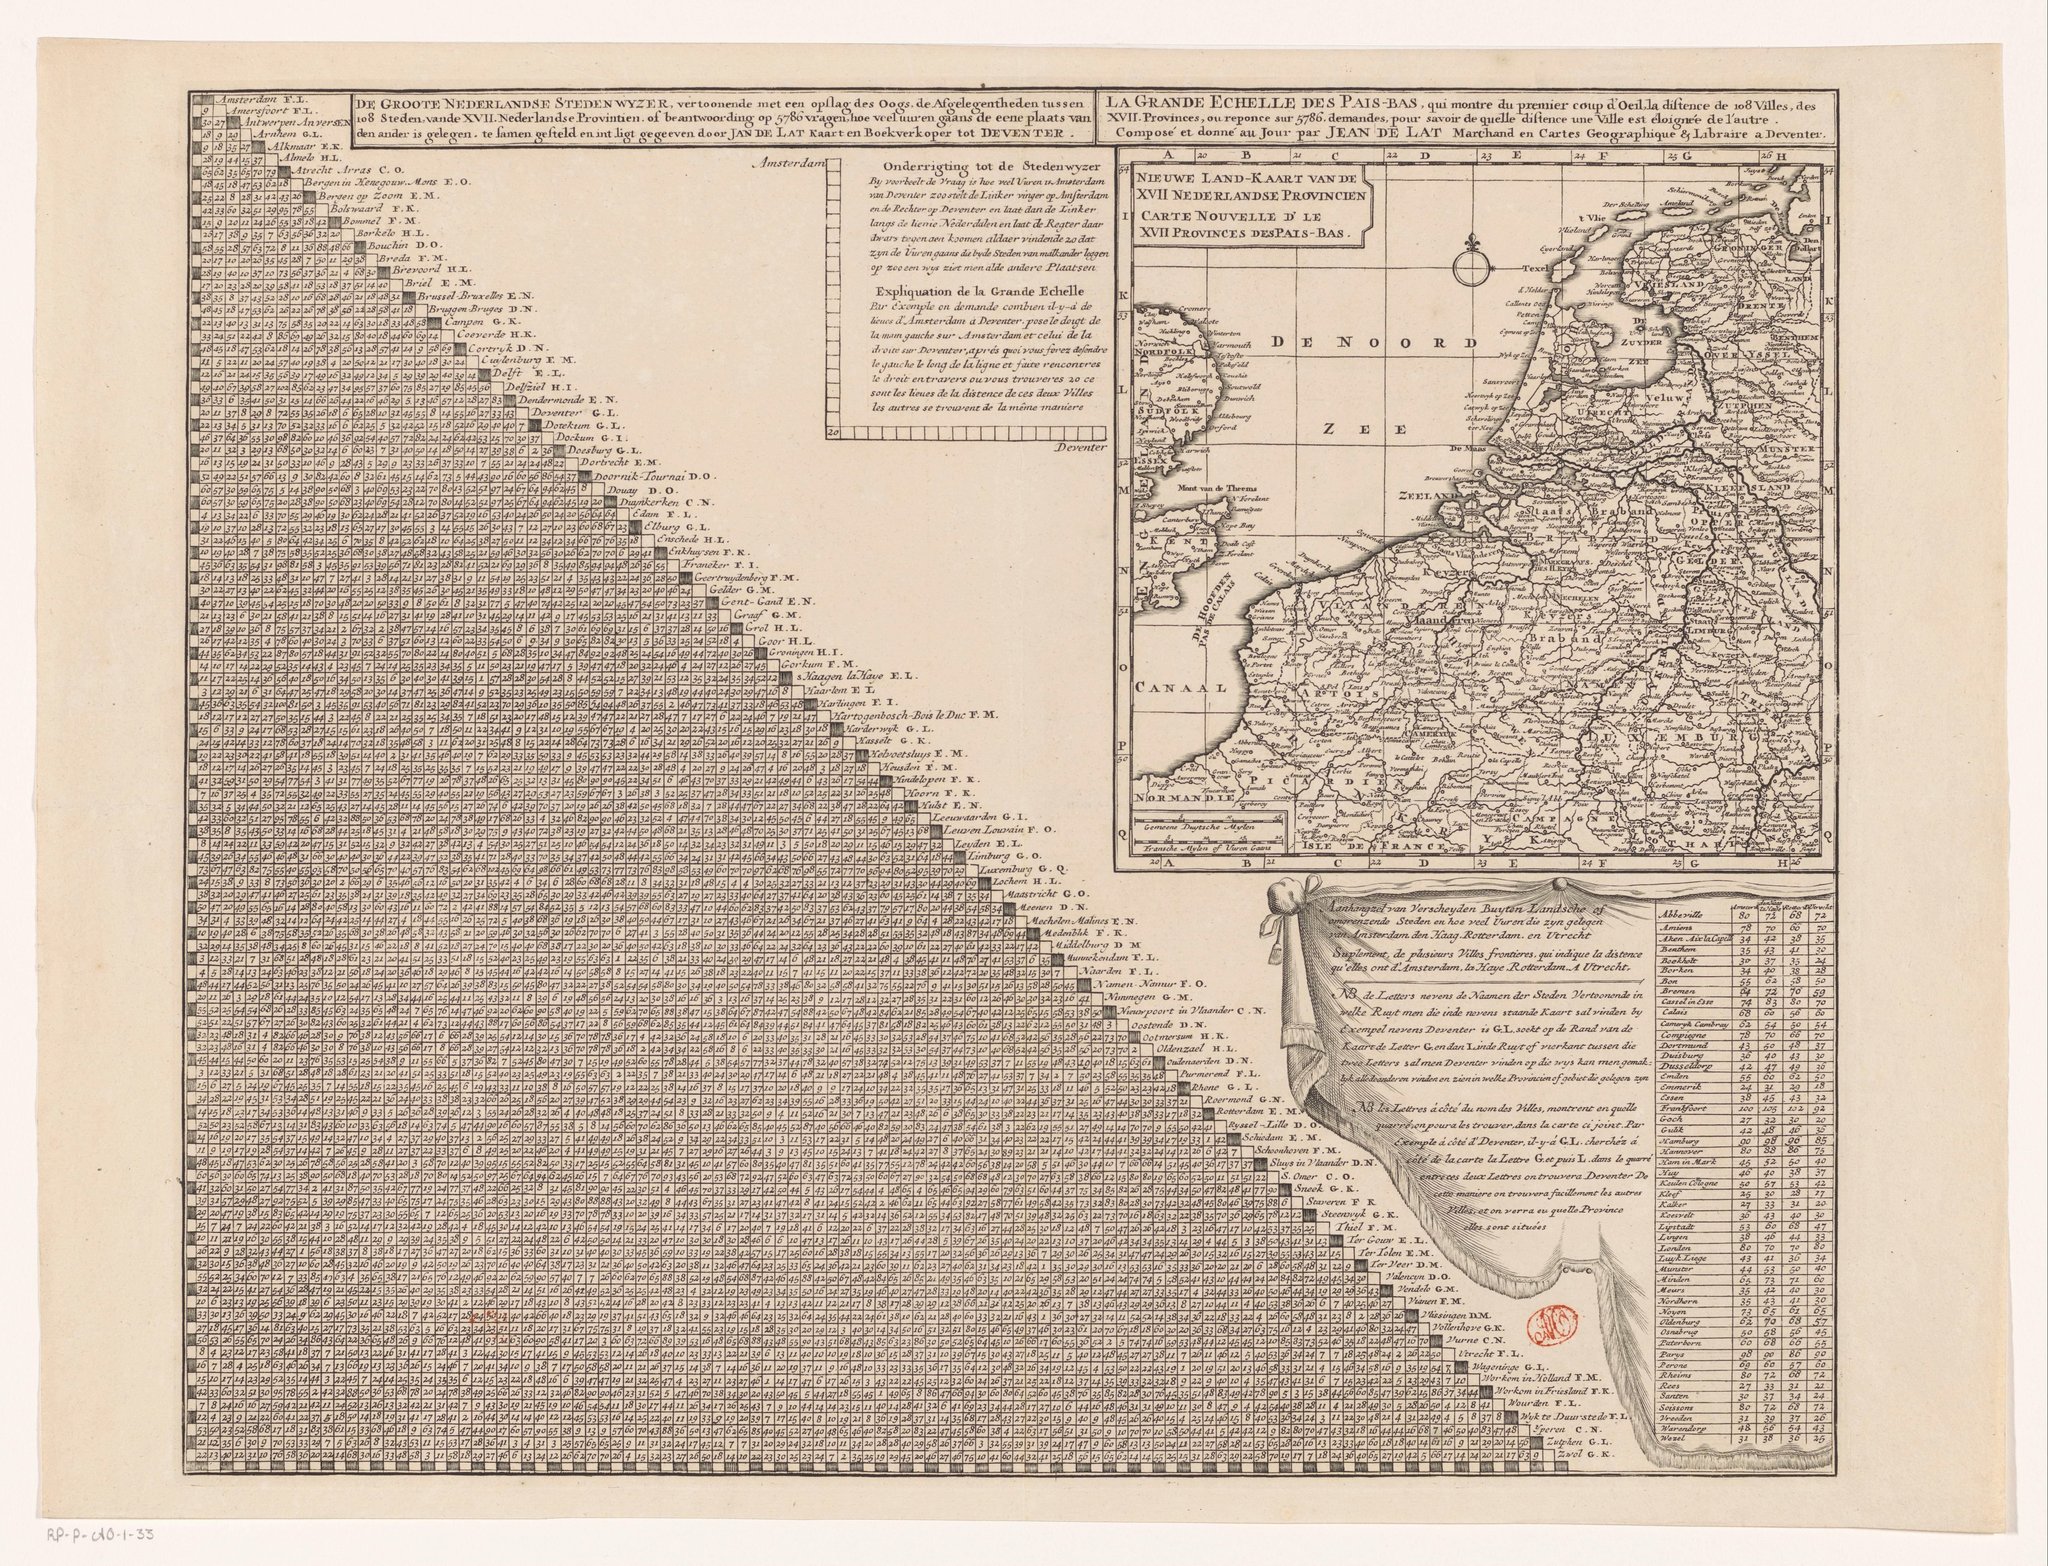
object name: print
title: Kaart van de Zeventien Provinciën met afstandstabel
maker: jan de lat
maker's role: bookseller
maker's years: 1683-1756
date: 1731-1740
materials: paper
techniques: engraving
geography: deventer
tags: maps of separate countries or regions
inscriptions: collector's mark: Lugt 195, collector's mark: Lugt 2228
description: Links een afstandstabel waarin staat hoeveel loopuren 108 belangrijke steden van de Zeventien Provinciën van elkaar vandaan liggen. Rechts een kaart van de Zeventien Provinciën, voorzien van een zoekrooster, een gradenverdeling langs de randen en linksonder een schaalstok: Gemeene Duytsche mylen en Fransche mylen of uuren gaans. Links van de kaart staat een gebruiksaanwijzing van de afstandstabel. Onder de kaart staat een afstandstabel met uitleg waarin het aantal loopuren tussen verschillende buitenlandse steden en Amsterdam, Den Haag, Rotterdam en Utrecht staat.